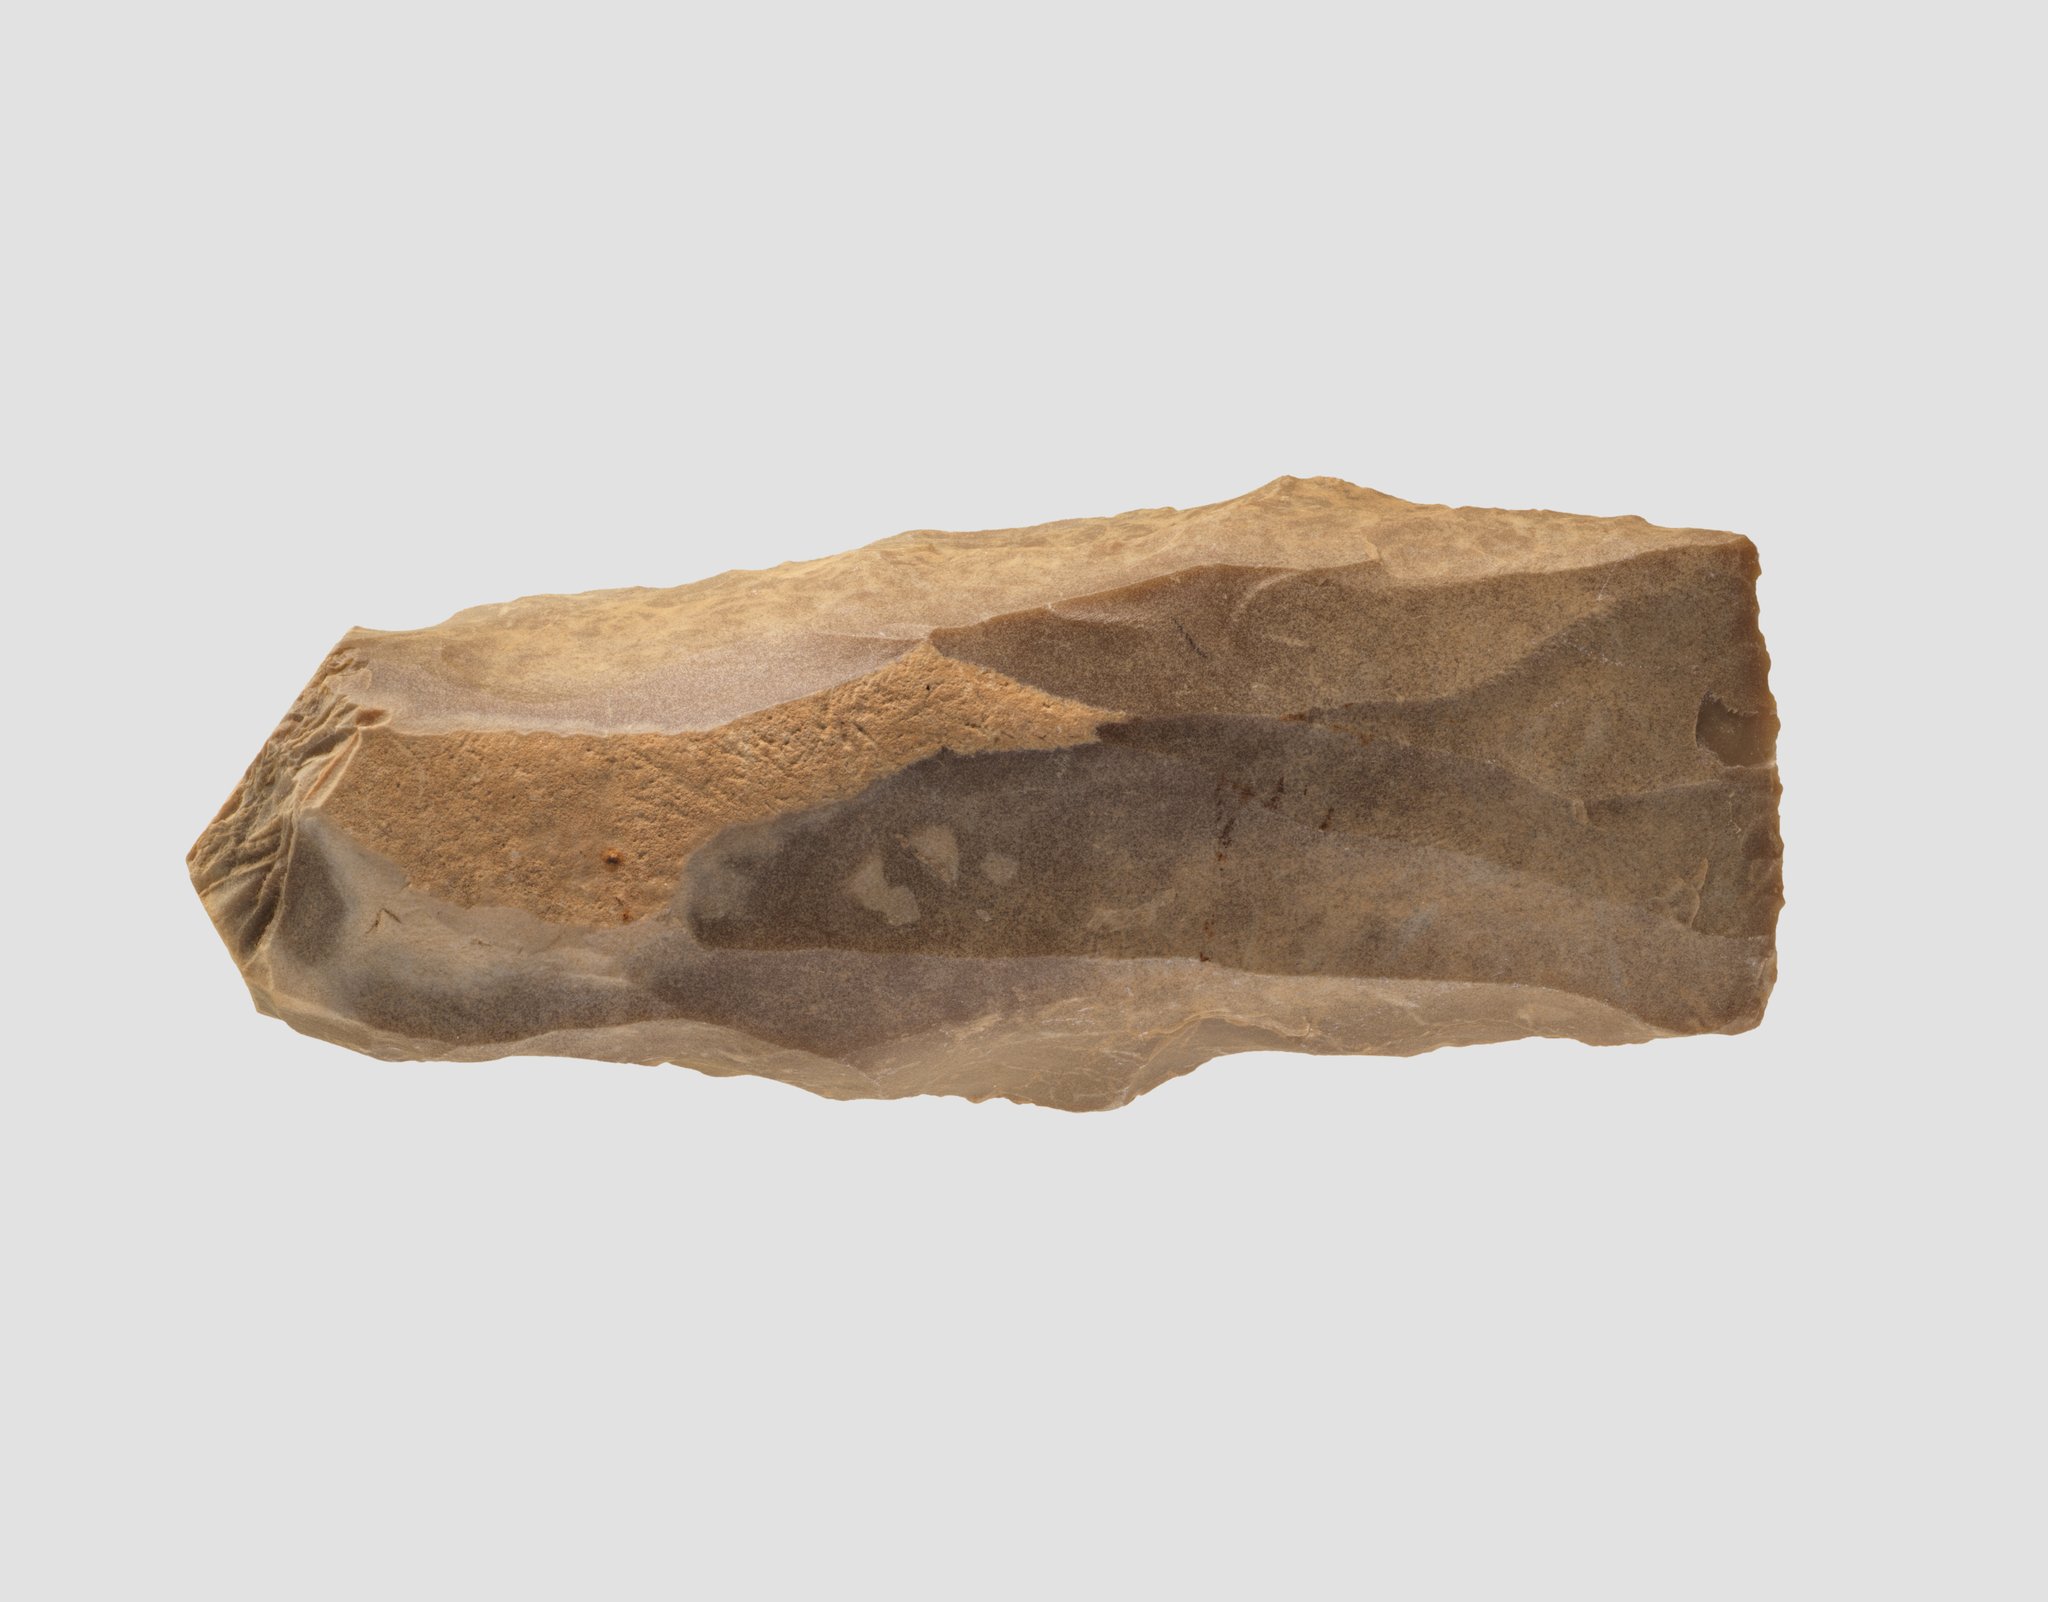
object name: chisel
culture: ghassulian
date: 4600-3600 BCE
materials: stone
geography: levant